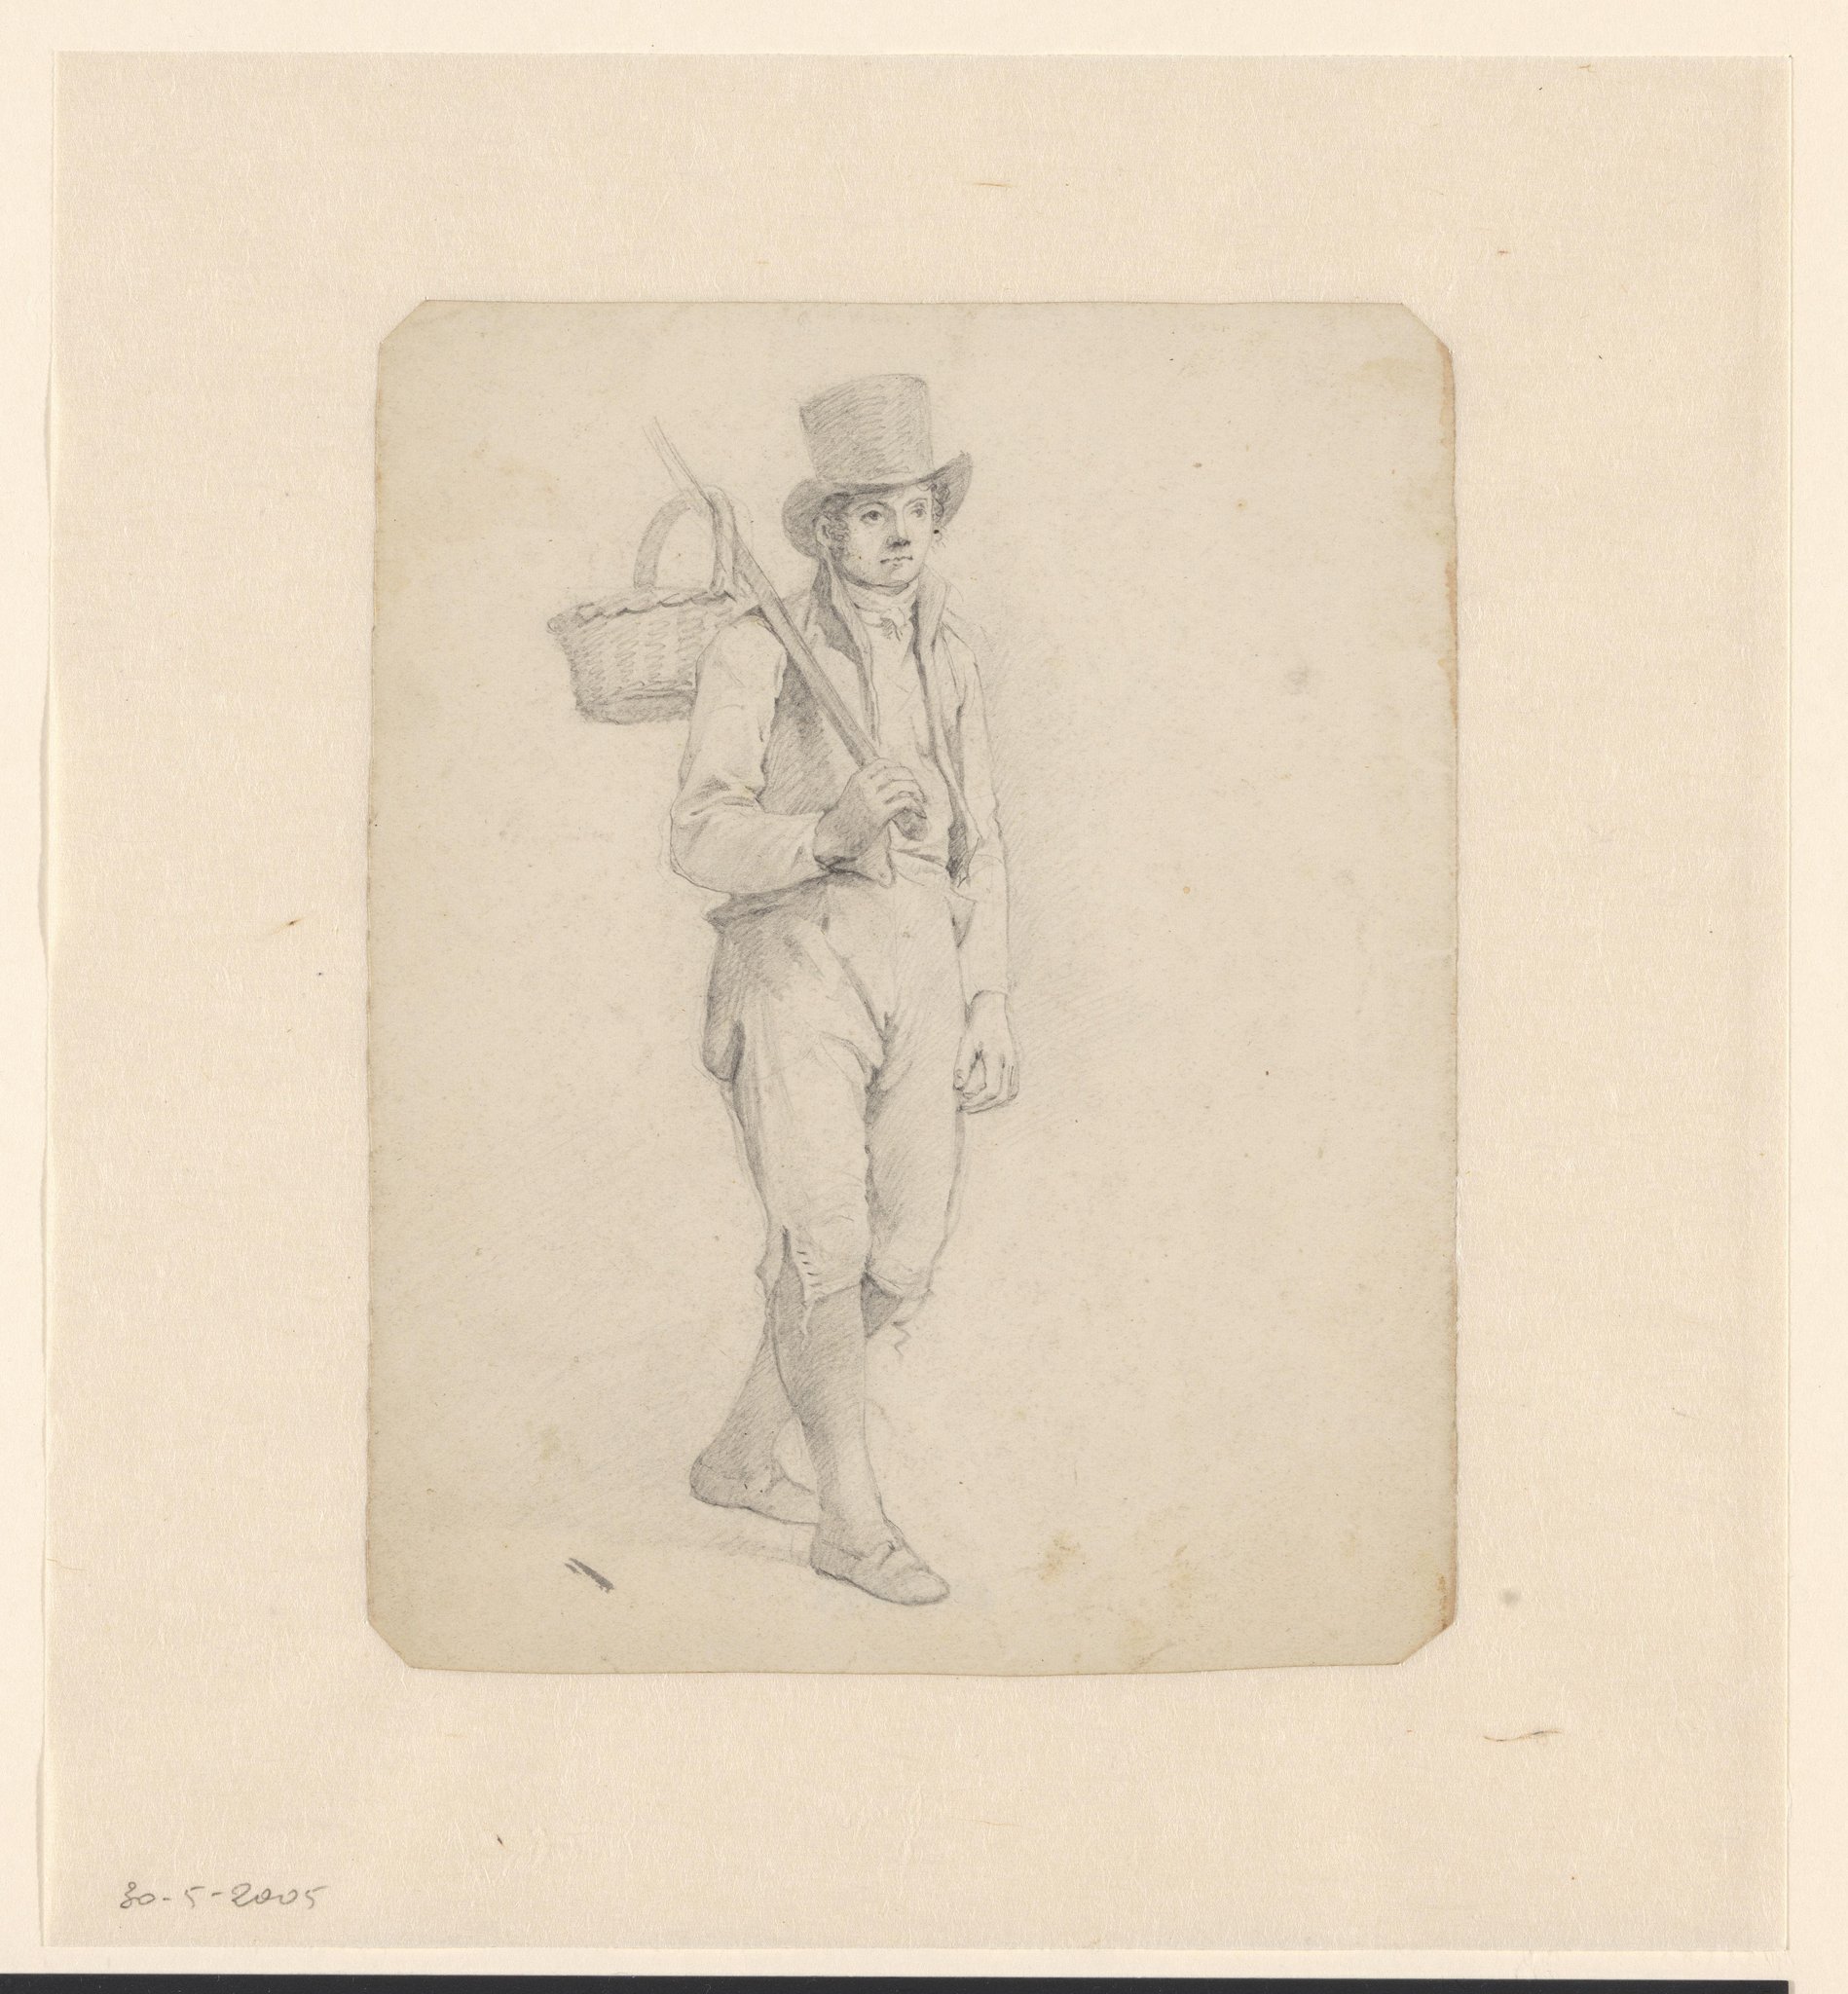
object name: drawing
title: Man, die over zijn schouder een mand aan een stok draagt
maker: Anonymous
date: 1800-1900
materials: paper, pencil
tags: container made of plant material other than wood: basket, male sex; man